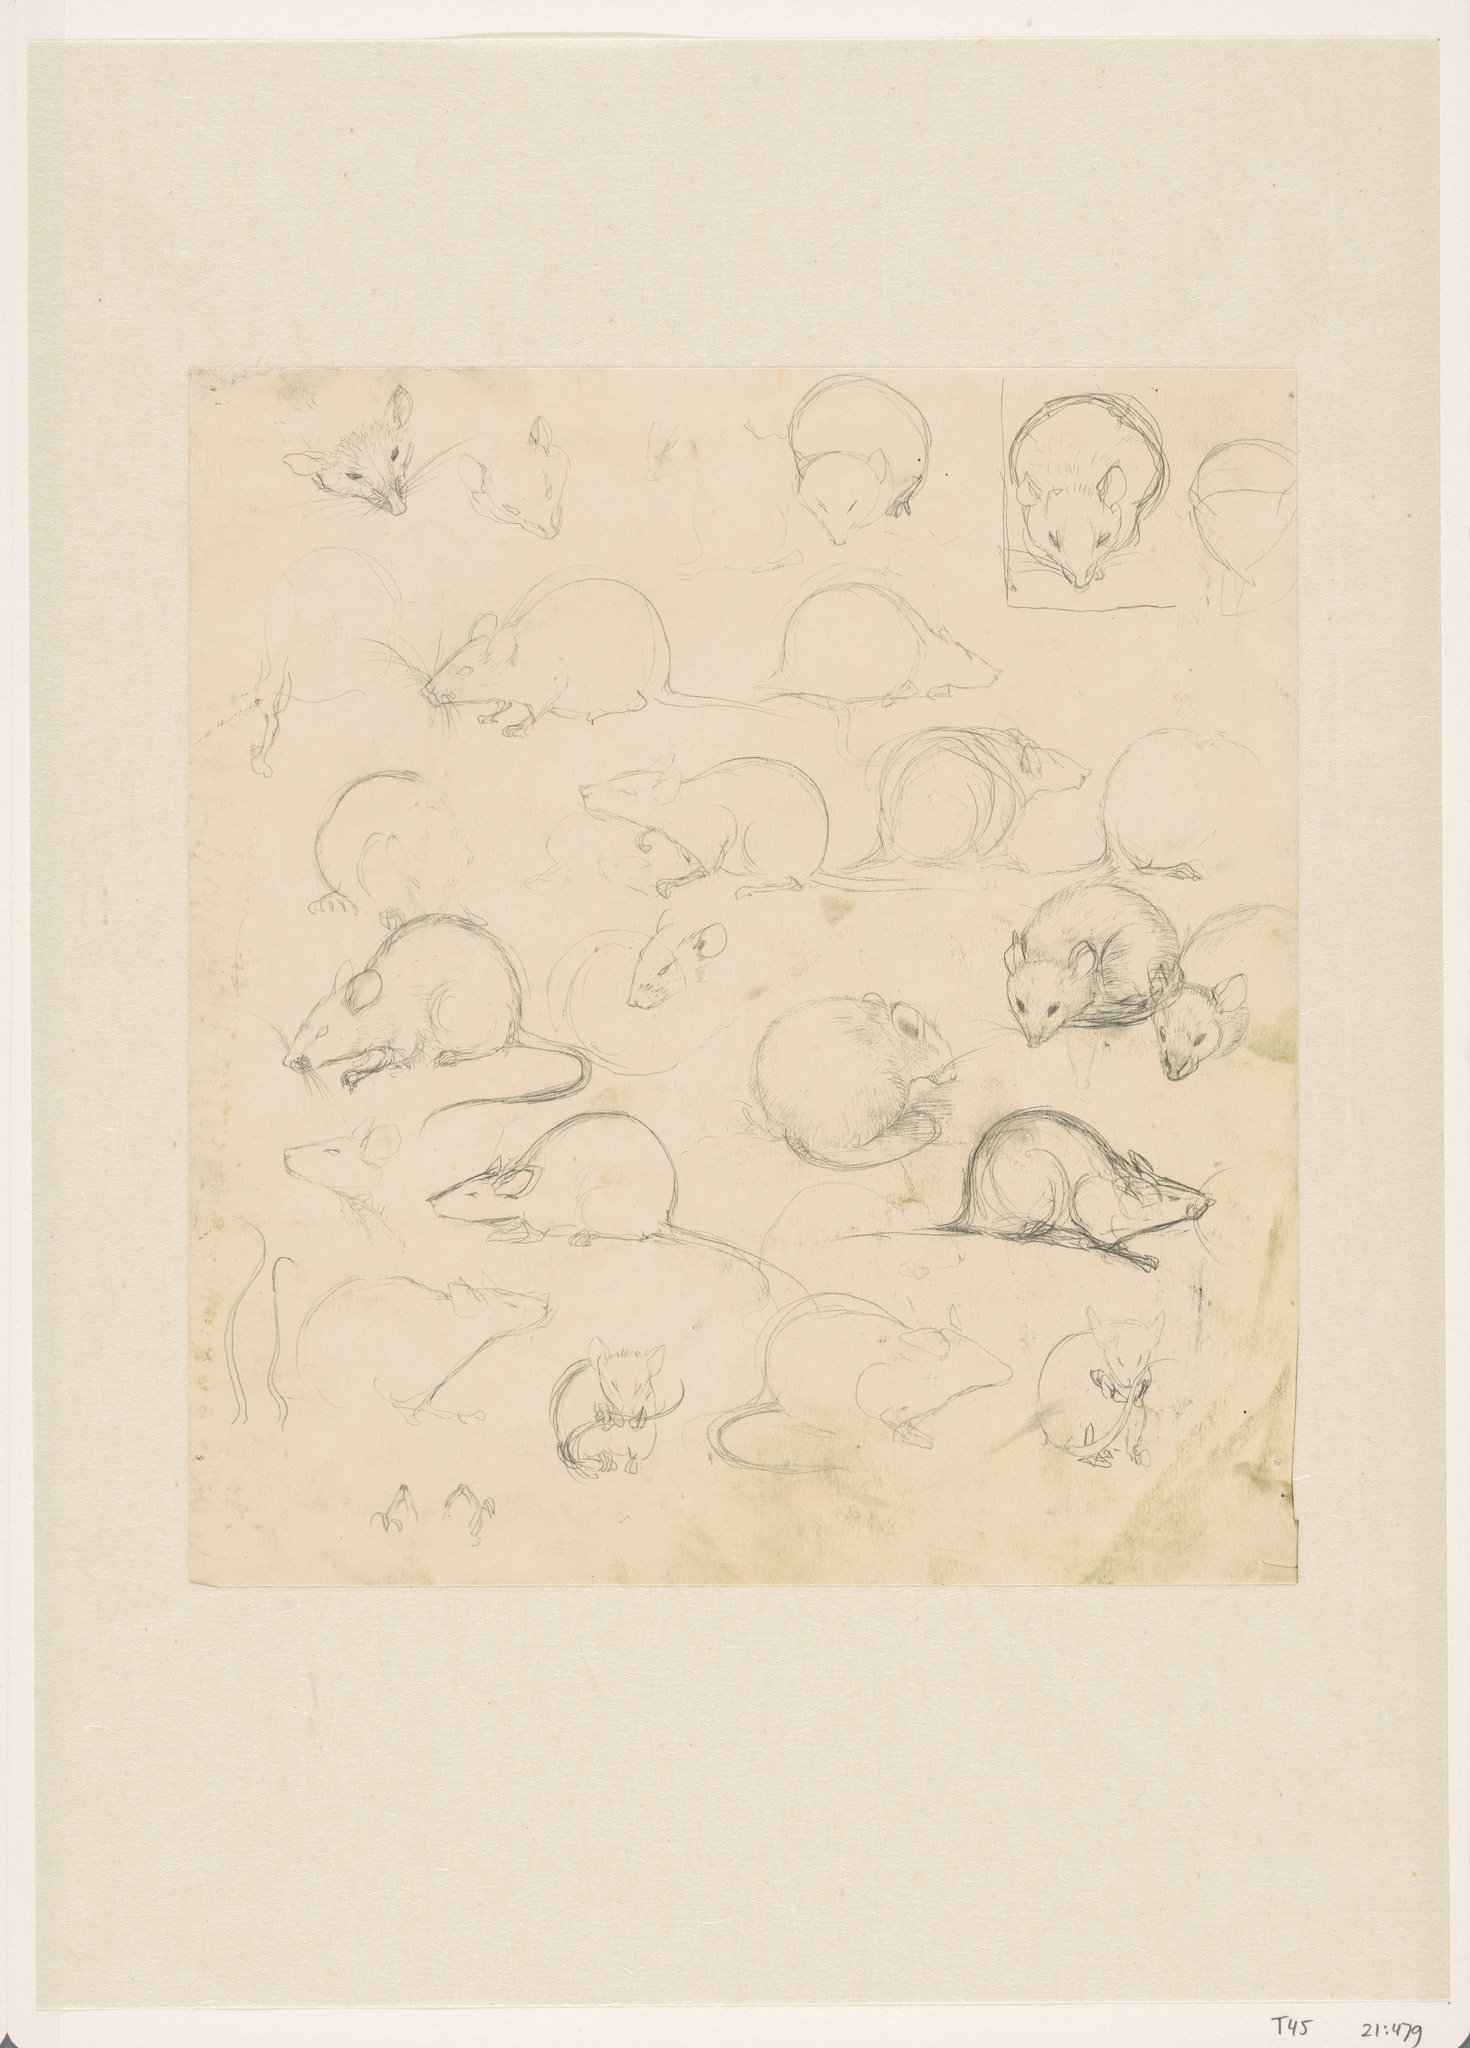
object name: design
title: Studieblad met muizen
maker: jan mankes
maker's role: draughtsman, painter, print maker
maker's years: 1889-1920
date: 1914-1916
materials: paper, pencil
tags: rodents: mouse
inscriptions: collector's mark: Lugt 2228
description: Mogelijk een studie voor de prent Twee muizen, zie RP-P-1921-1922.